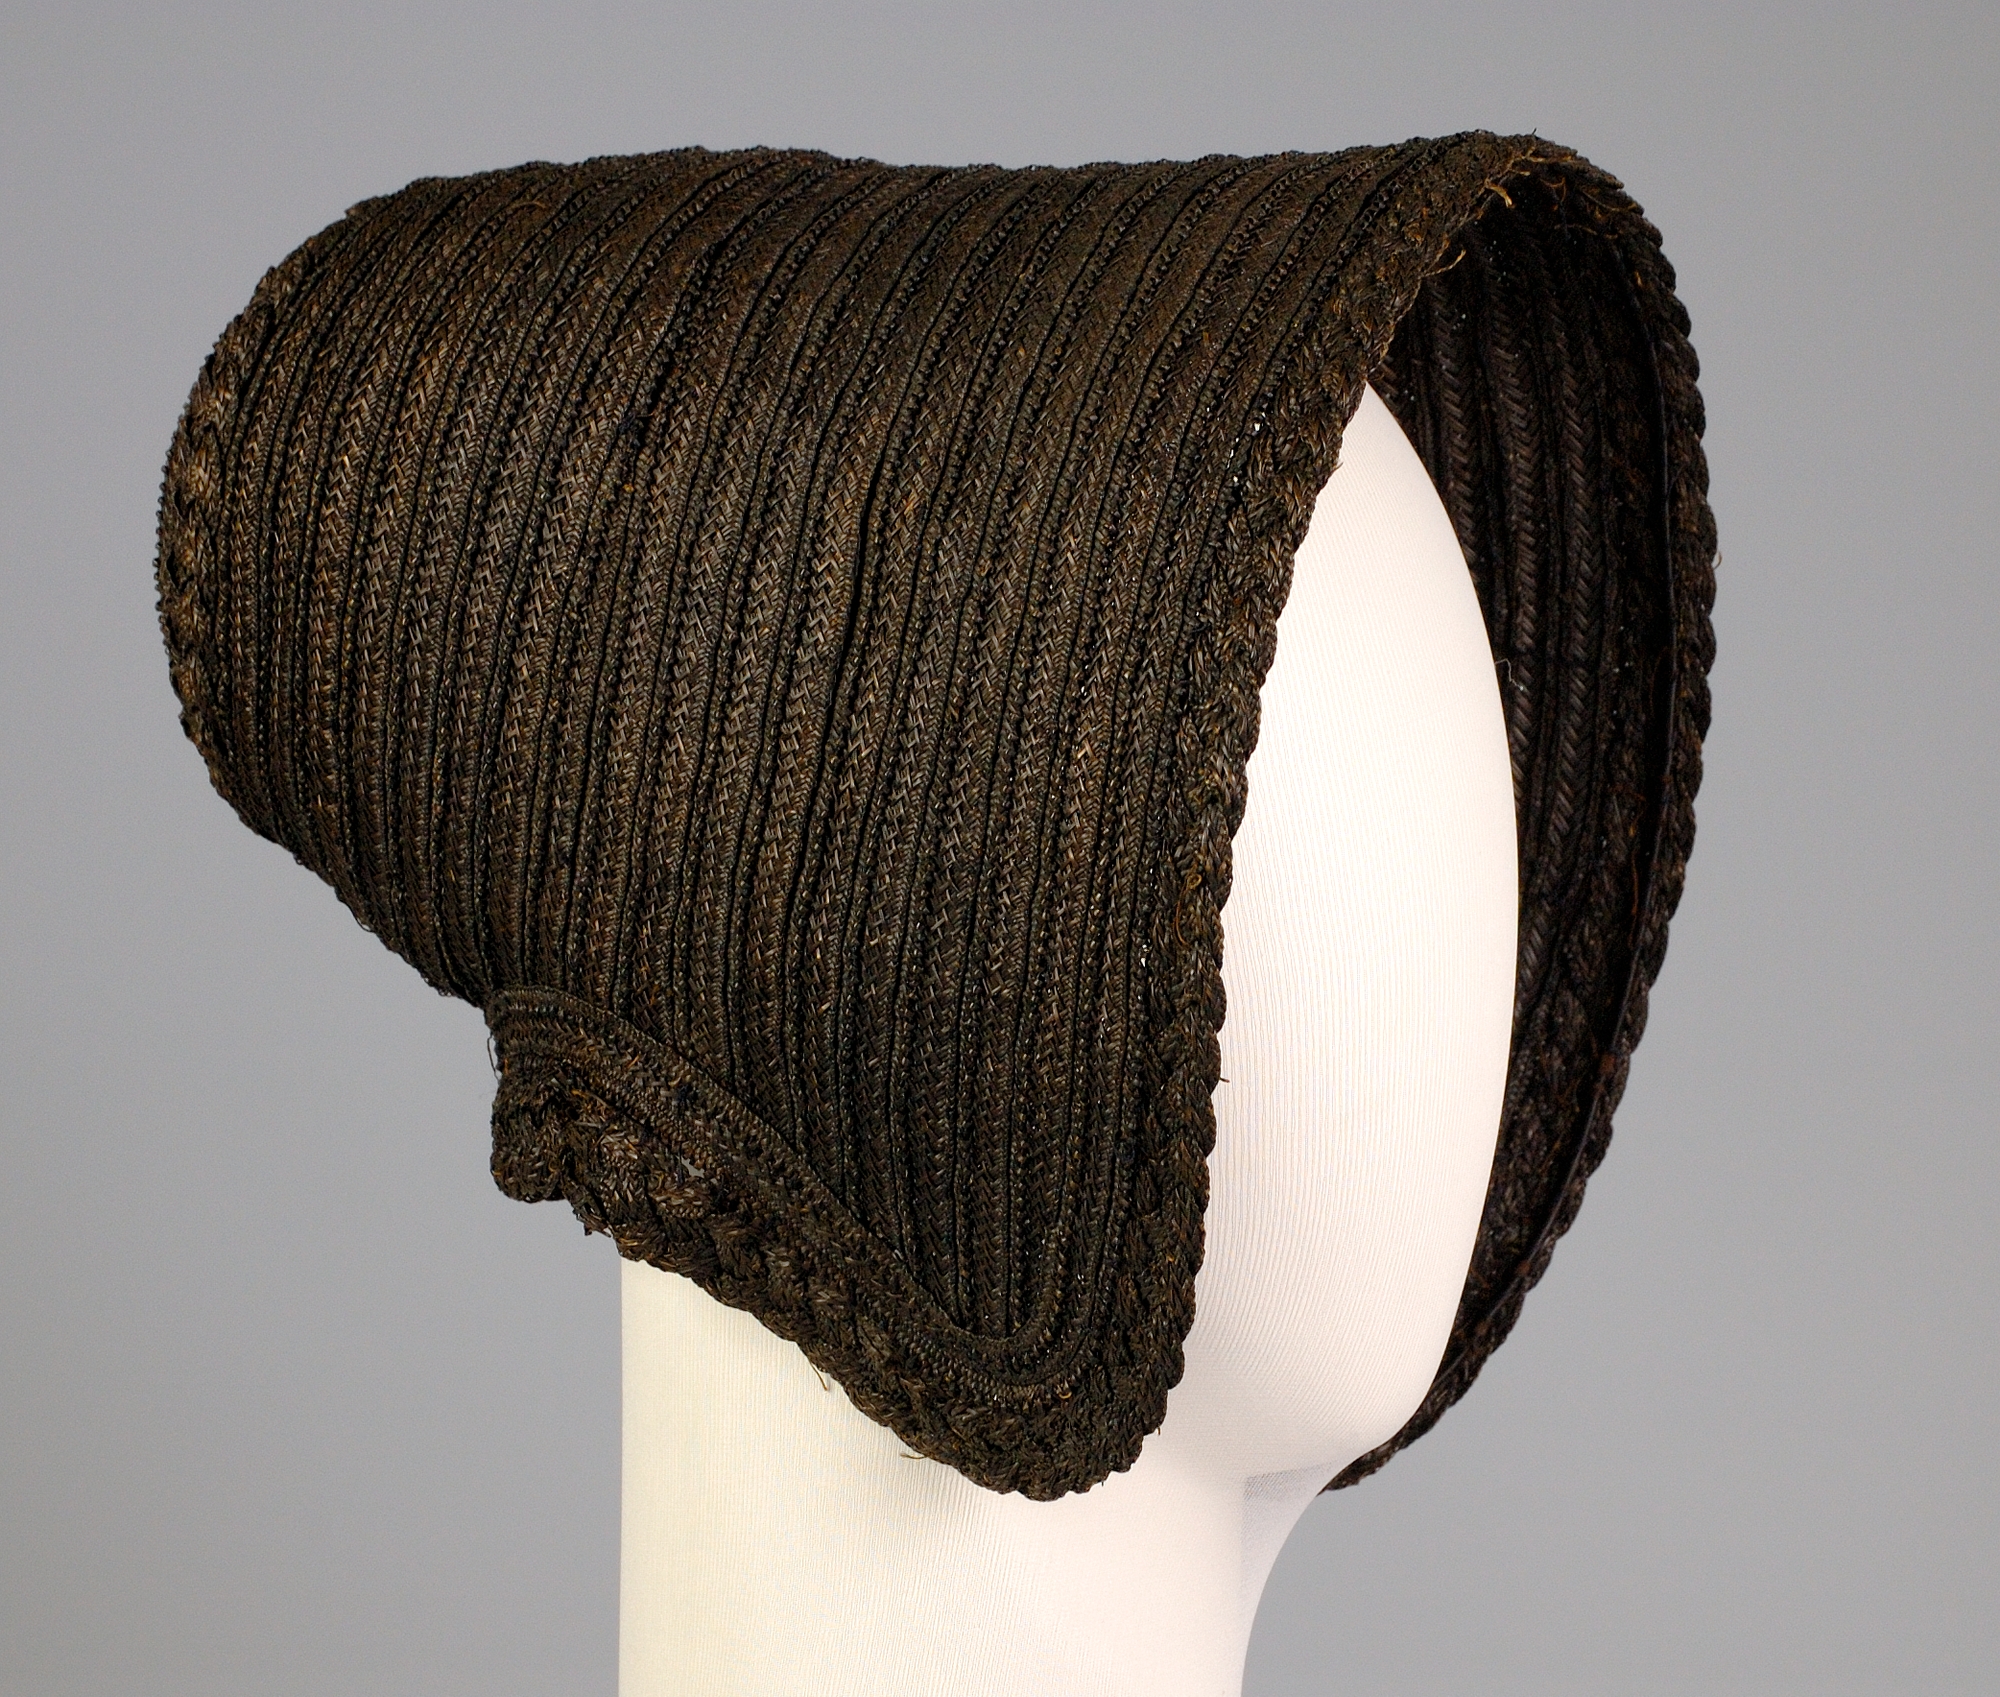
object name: mourning poke bonnet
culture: american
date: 1845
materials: silk, fiber